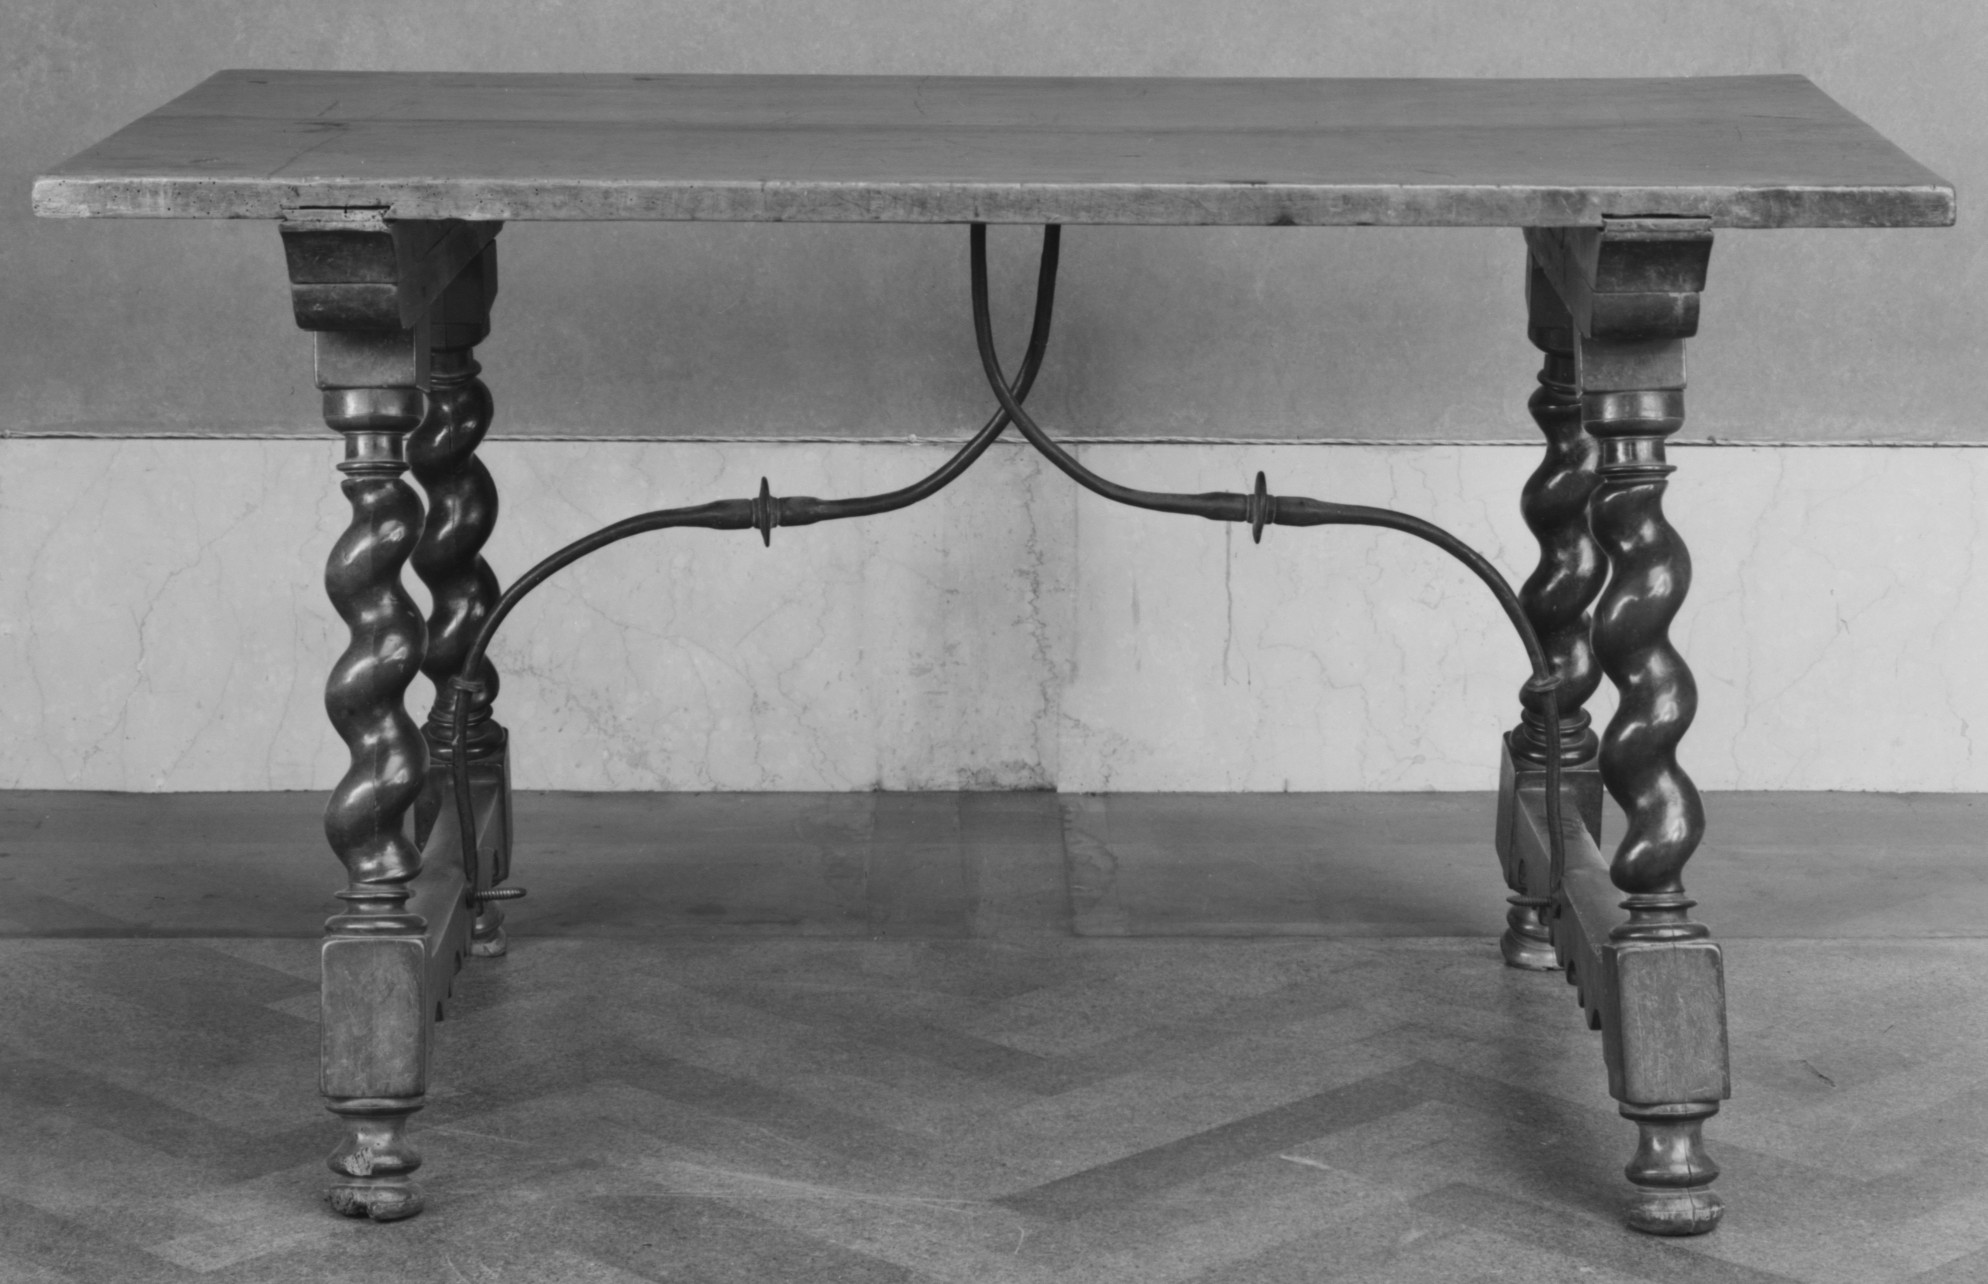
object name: table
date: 1601-1700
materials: wood, iron